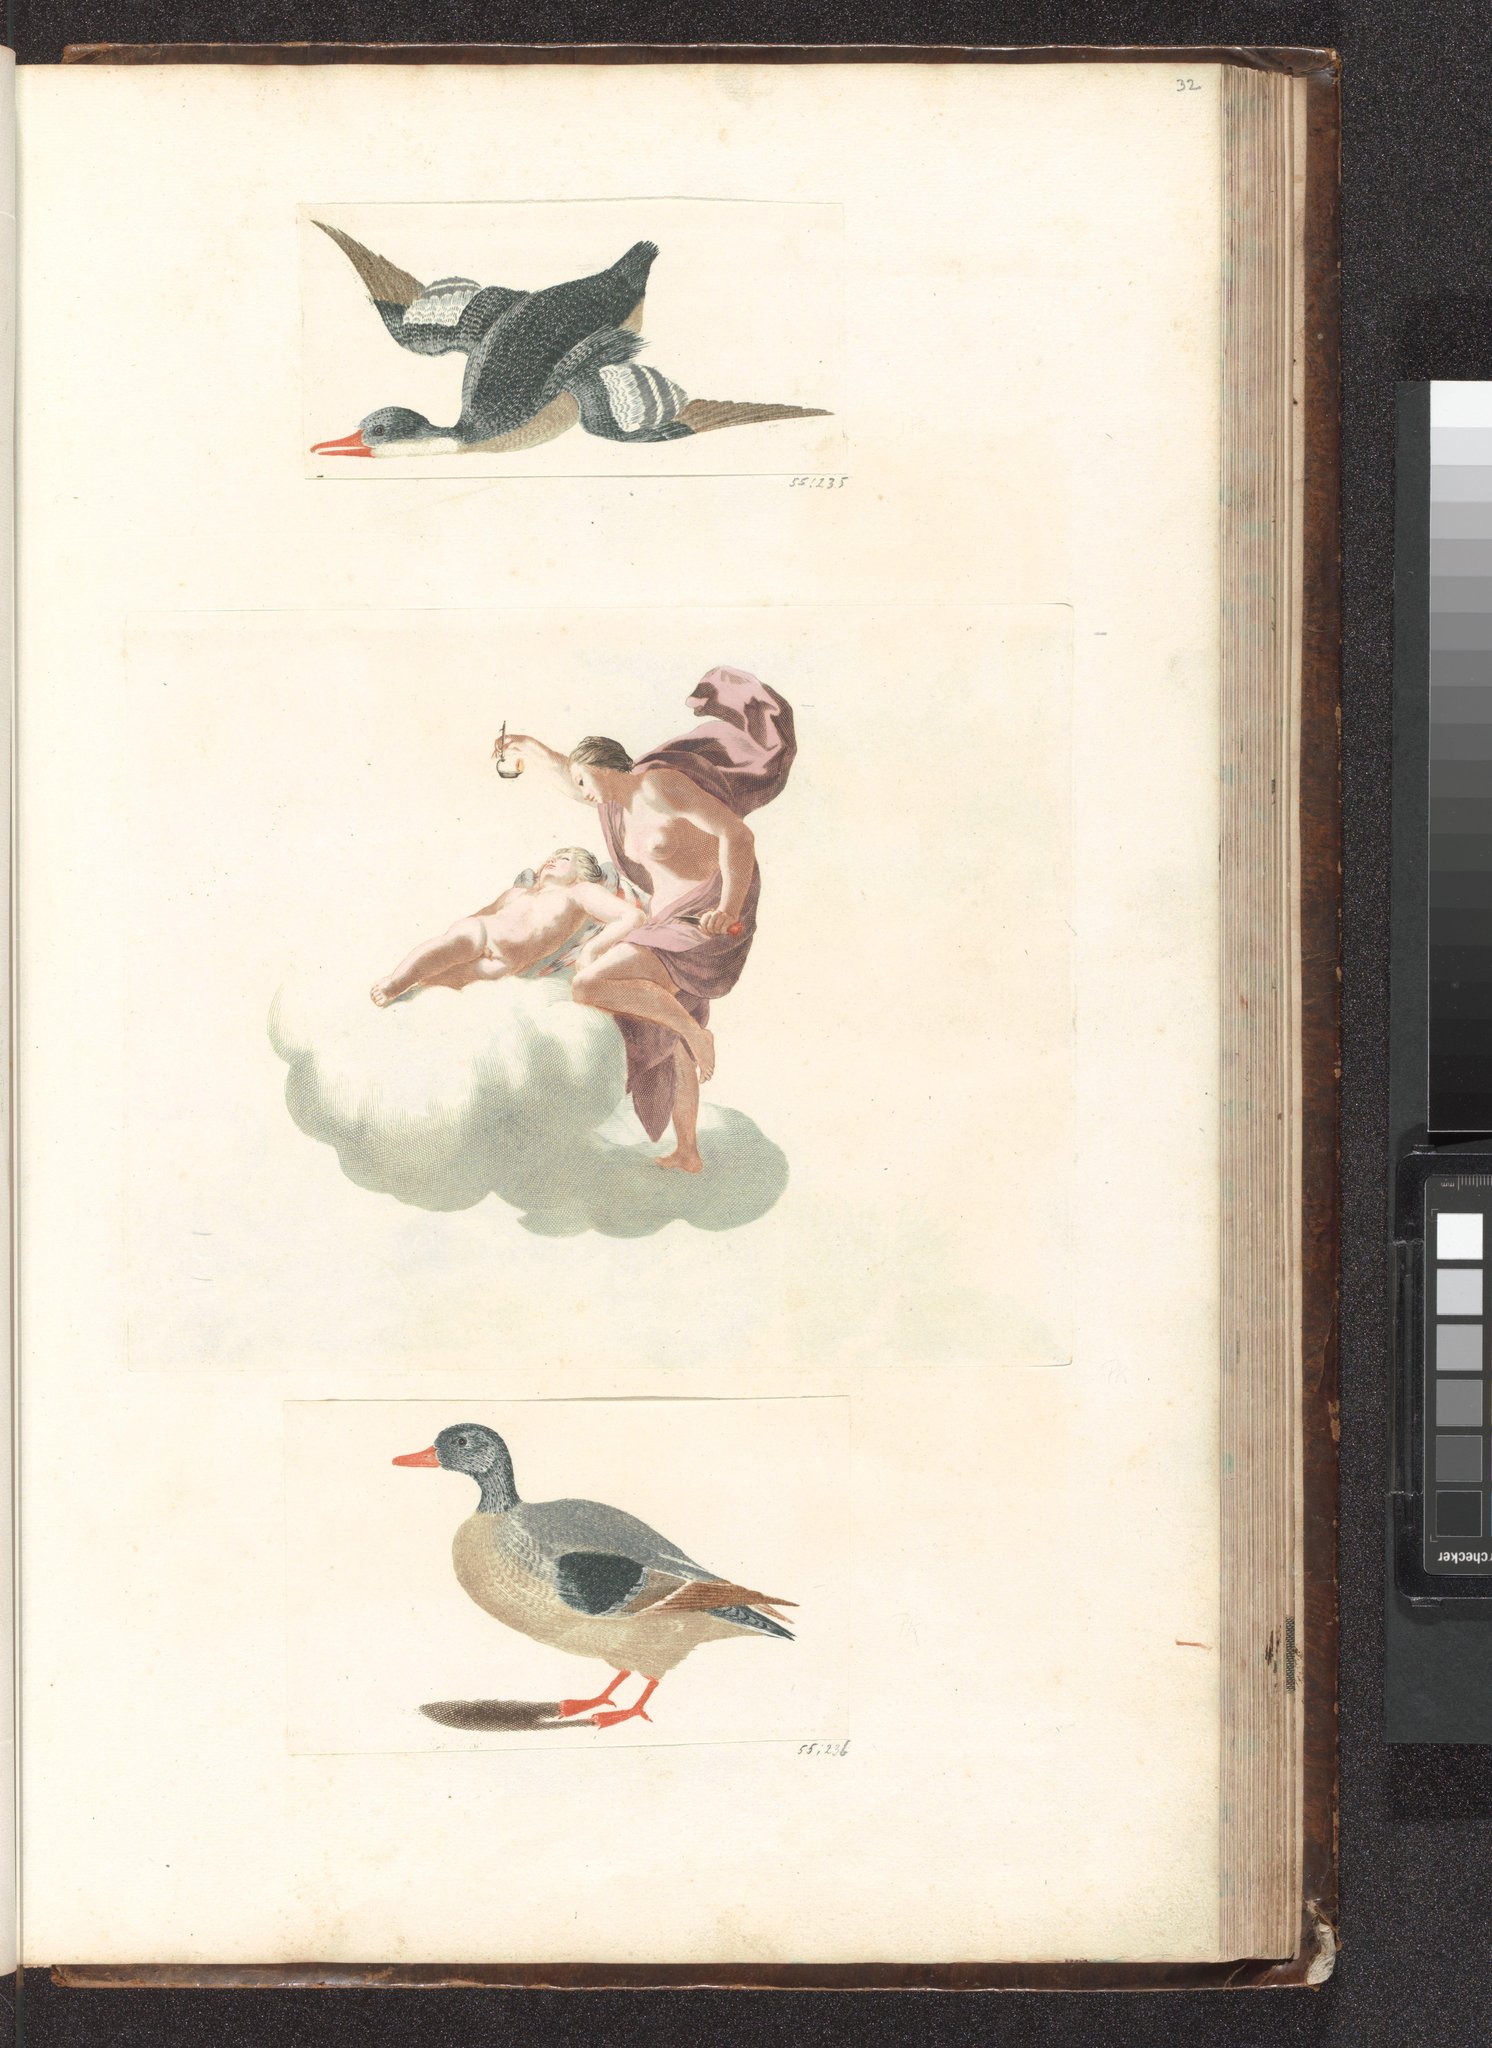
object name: print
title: Staande eend naar links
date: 1688-1698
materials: paper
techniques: printing, engraving, lithography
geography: netherlands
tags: water-birds: duck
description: Deze prent maakt deel uit van een album.